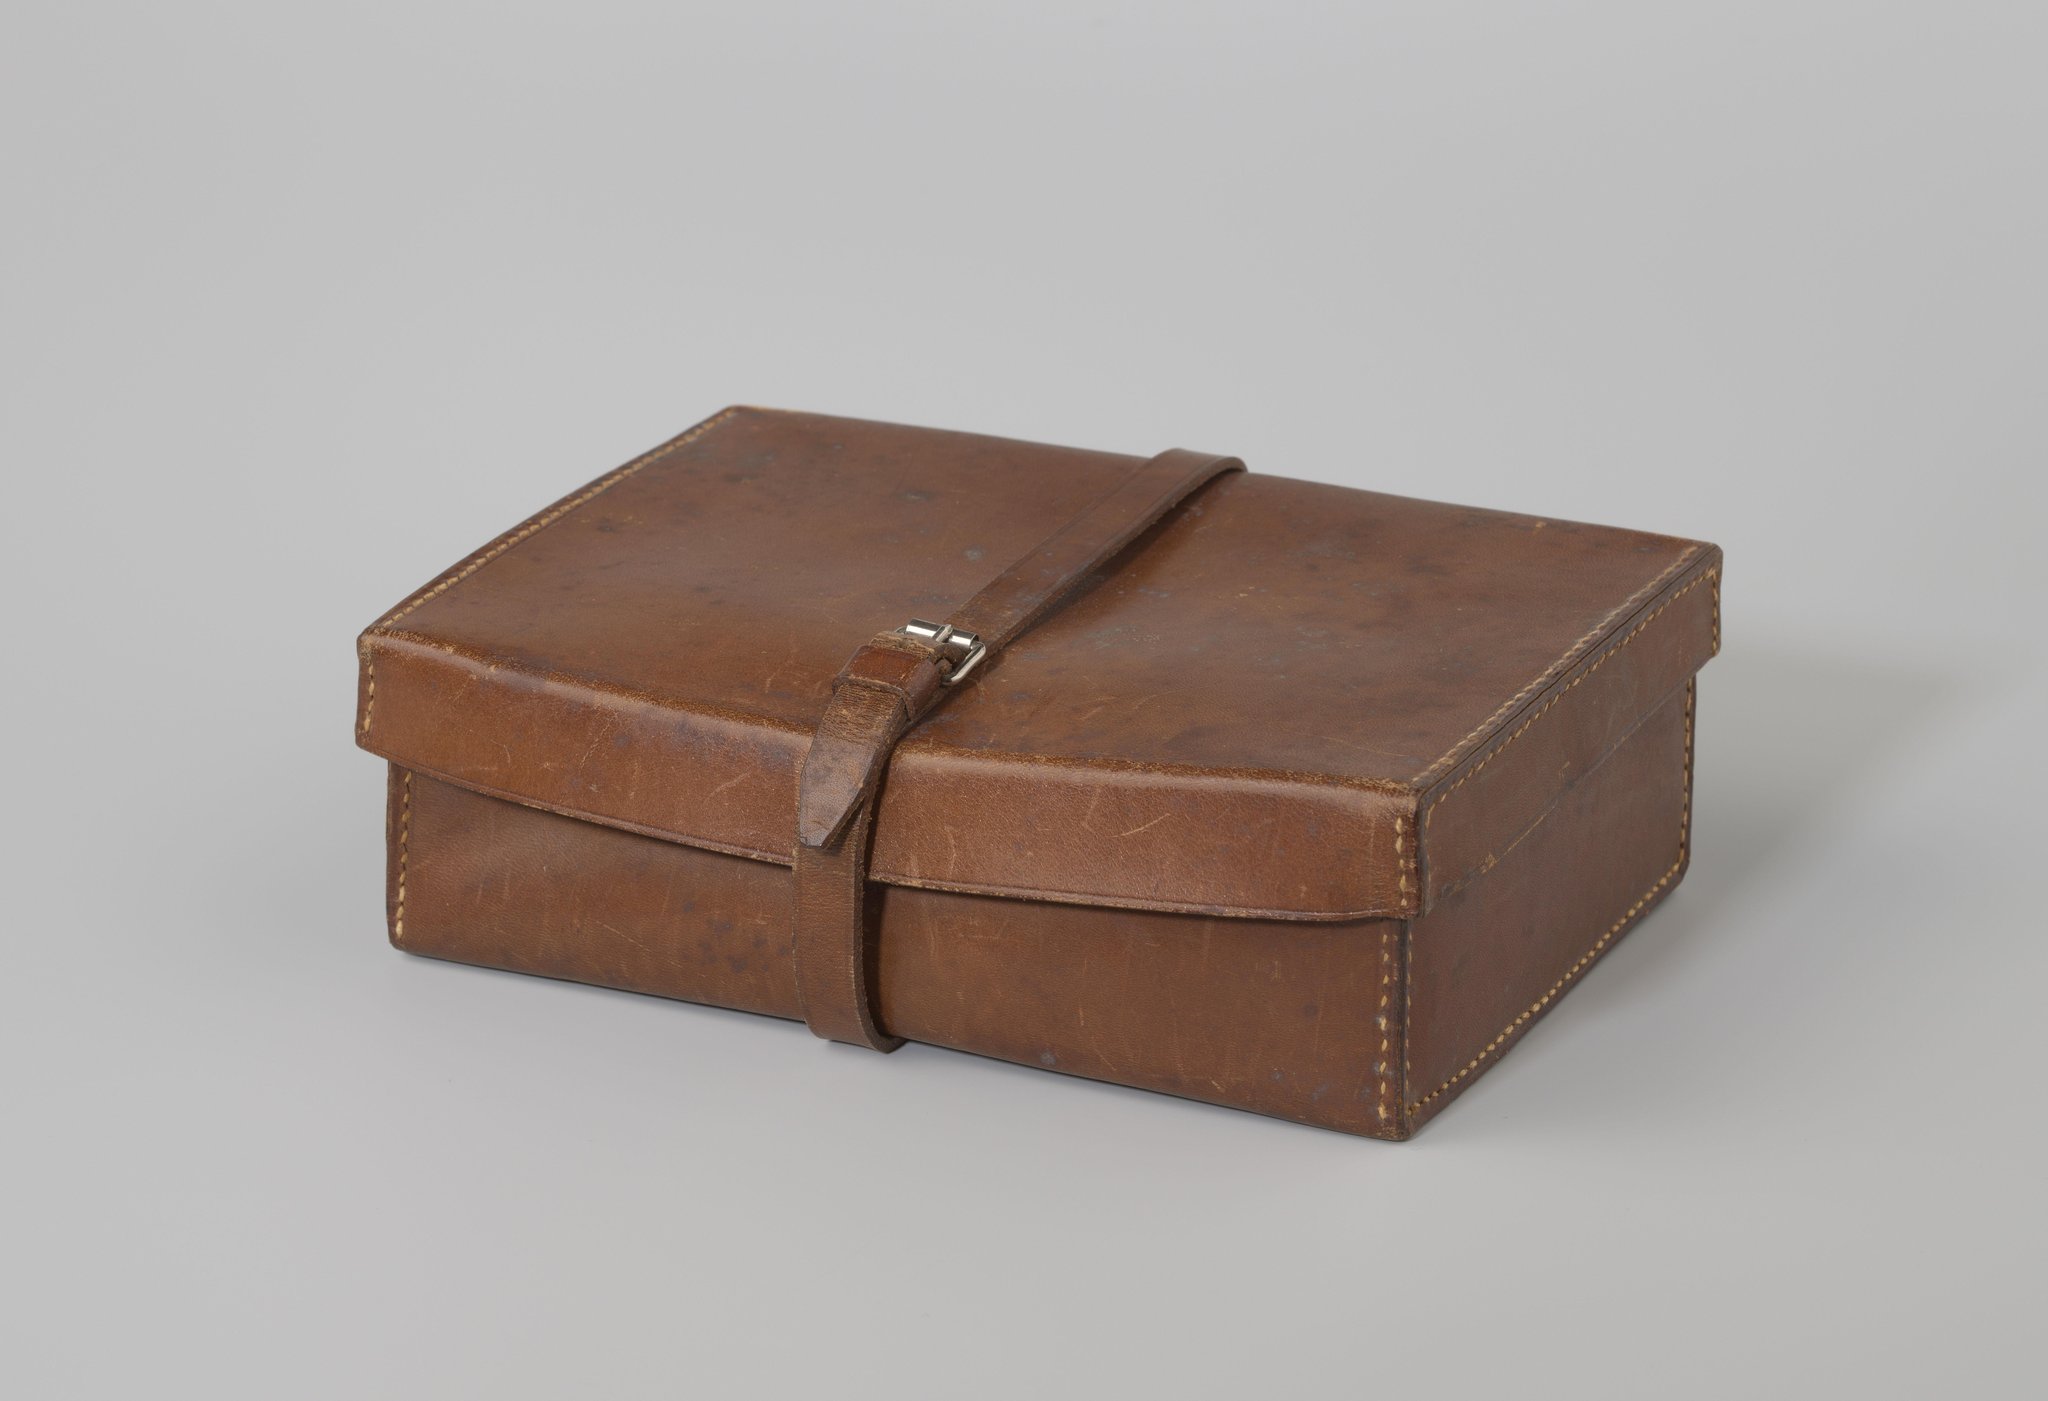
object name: suitcase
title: Kleine koffer van bruin leer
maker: Anonymous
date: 1900-1925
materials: leather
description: Dit object is onderdeel van de nalatenschap van Isabel Elon-Wachenheimer (1928-2010). Tot haar overlijden behoorde het samen met de andere objecten uit de nalatenschap tot haar privédomein van Isabel Wachenheimer. In die particuliere context zijn deze objecten tezamen en individueel aandenkens - aan de jeugd, ouders en familie van Isabel Wachenheimer vóór en tijdens de Shoah en aan haar leven na de Tweede Wereldoorlog. Isabel Wachenheimer, die van juni 1943 tot mei 1945 gevangen zat in Kamp Westerbork, Theresienstadt, Auschwitz, Lenzing a/d Oberdonau (een buitenkamp van Mauthausen), overleefde de Shoah. Haar ouders – Eugène Wachenheimer en Else Wachenheimer-Moos - werden op 14 oktober 1944 in Auschwitz-Birkenau vermoord.